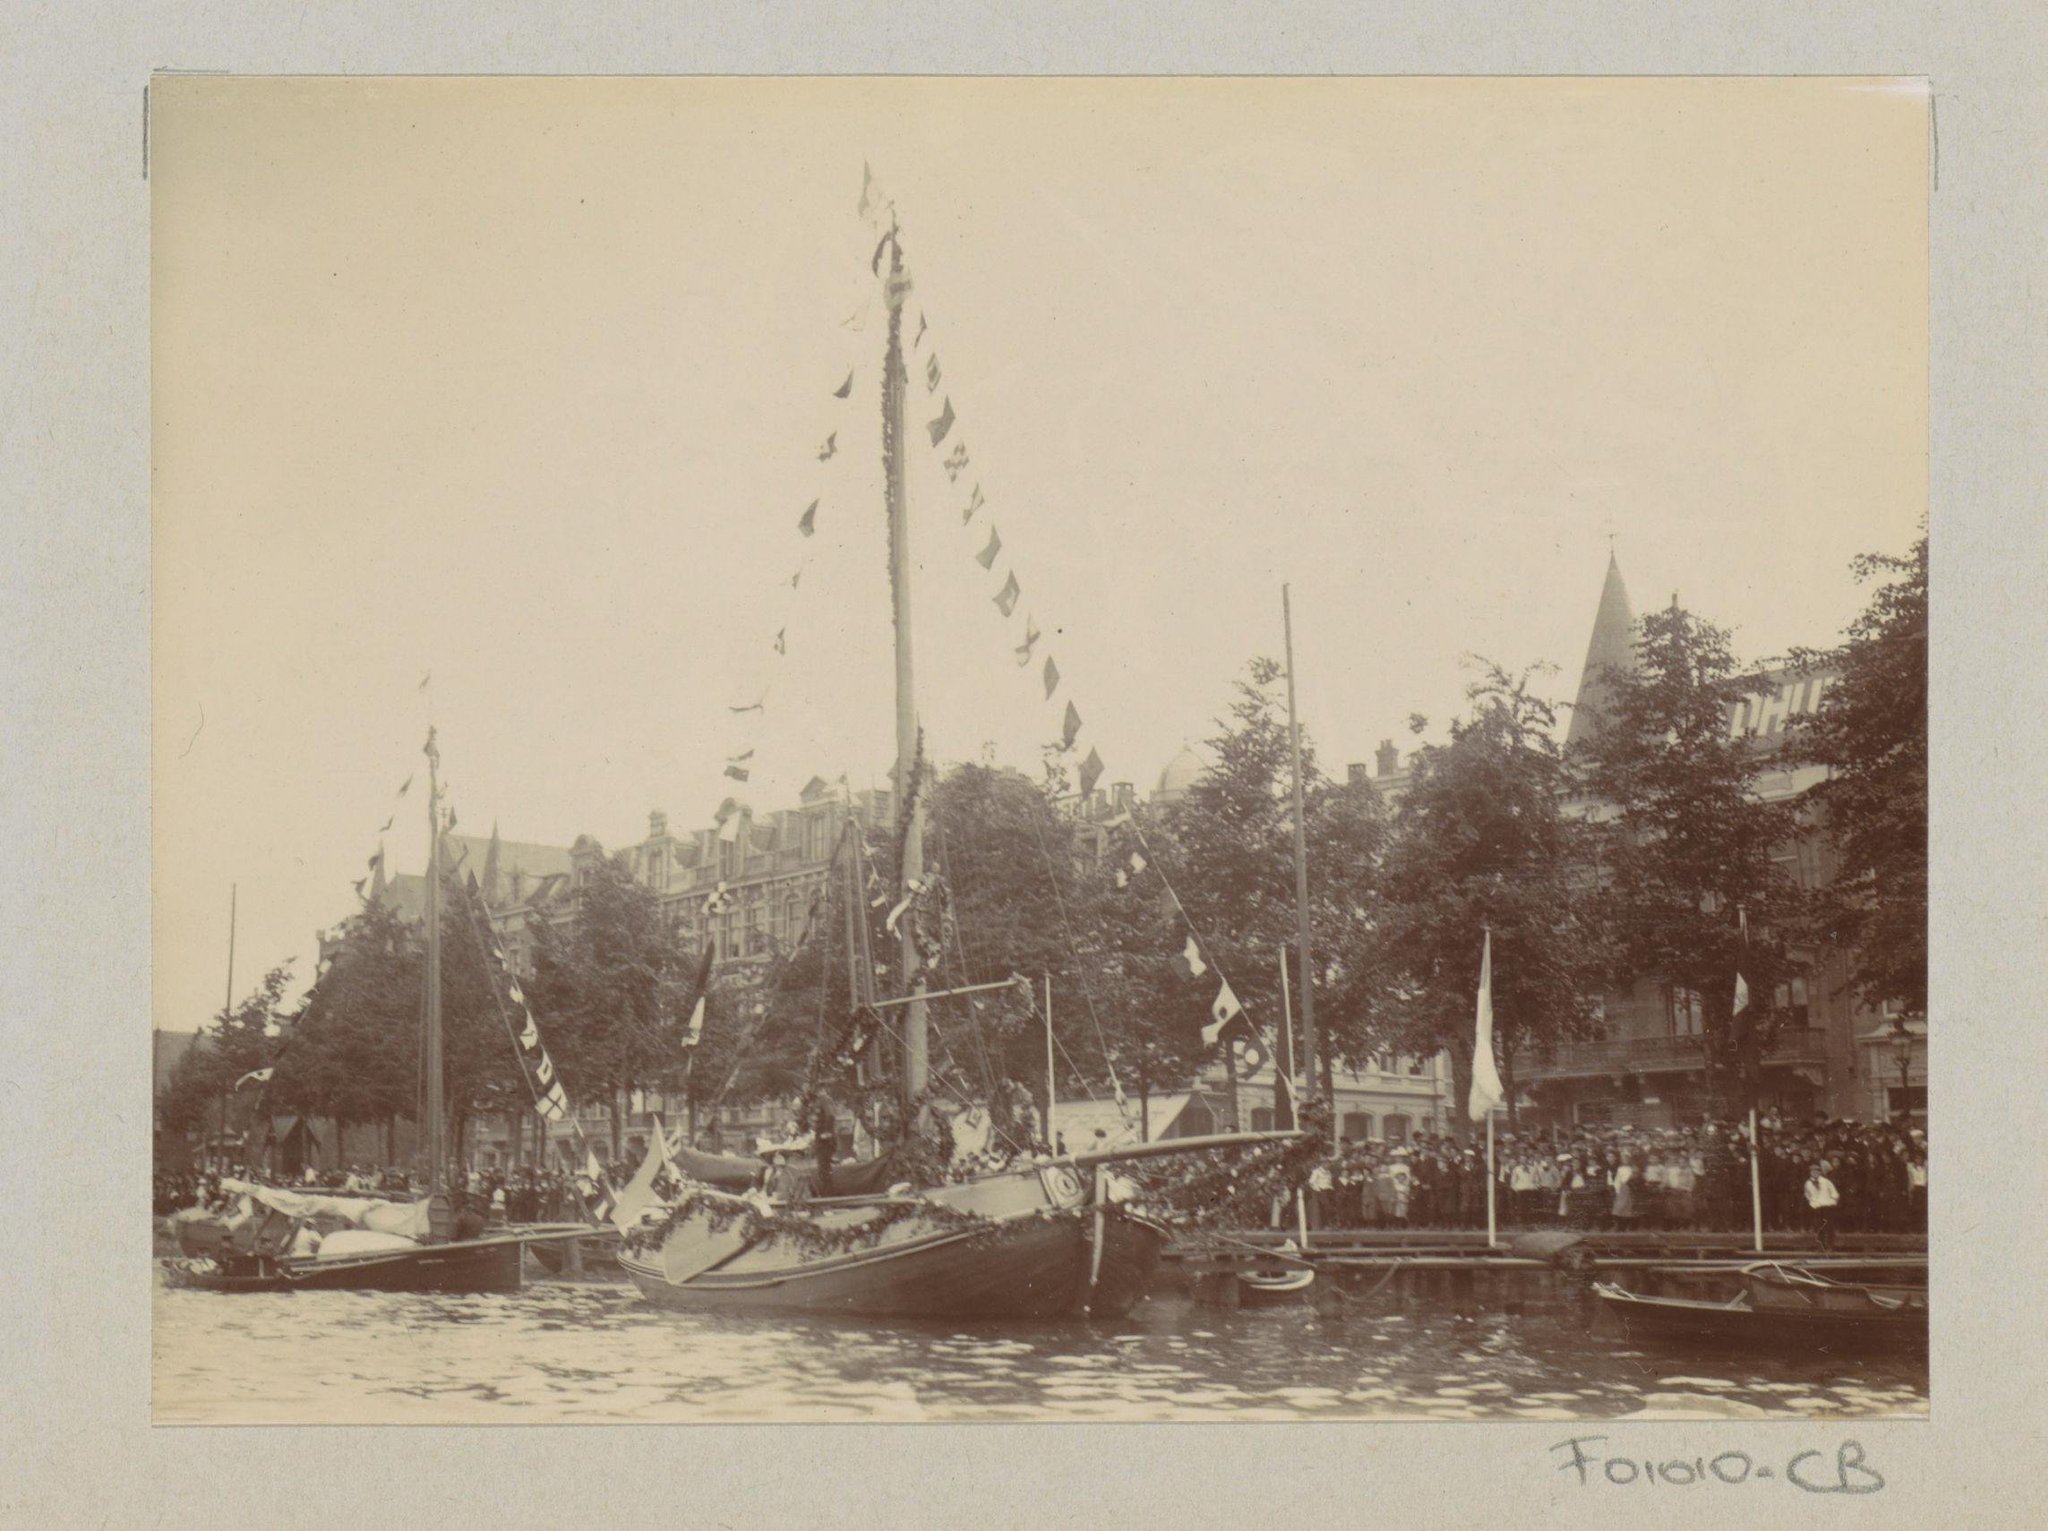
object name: photograph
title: Toeschouwers bij versierde boten aan de Amsteldijk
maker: Anonymous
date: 1906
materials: photographic support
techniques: gelatin silver print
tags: river, commemoration, jubilee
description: Onderdeel van Familiealbum met onder meer foto's van Wijnhandel Kraaij & Co. Bordeaux-Amsterdam.